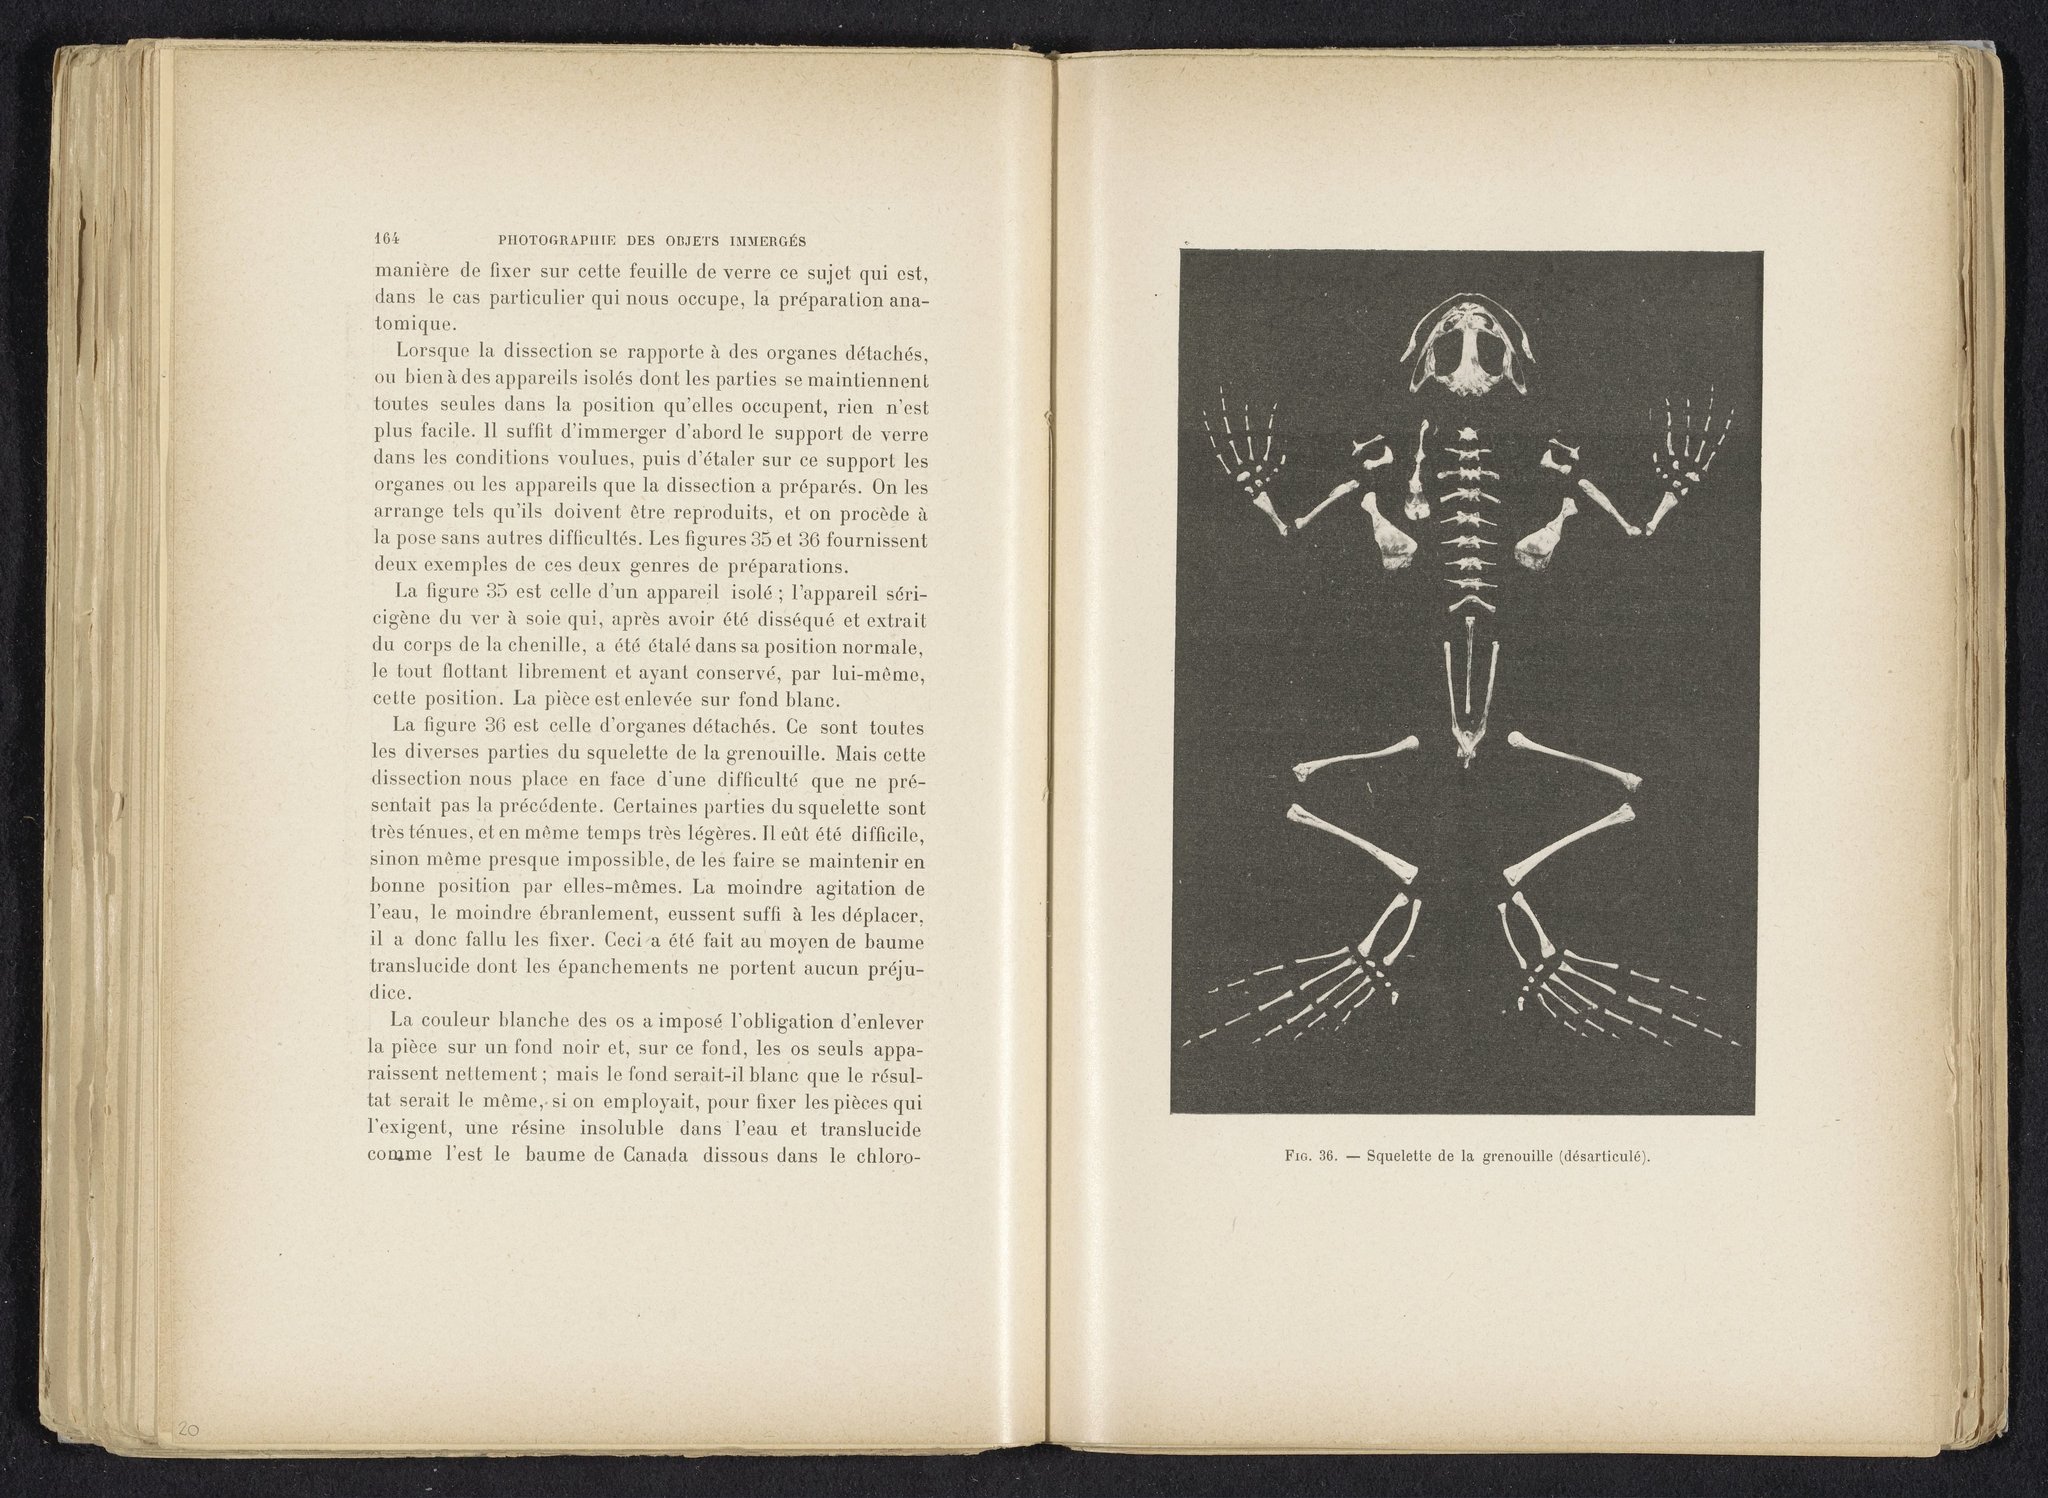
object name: photomechanical print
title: Skelet van een kikker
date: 1891-1901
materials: paper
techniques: autotype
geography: paris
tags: tailless amphibians: frog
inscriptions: number: ‘Fig. 36.’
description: Prent in album 'La photographie des objets immergés', 1901.